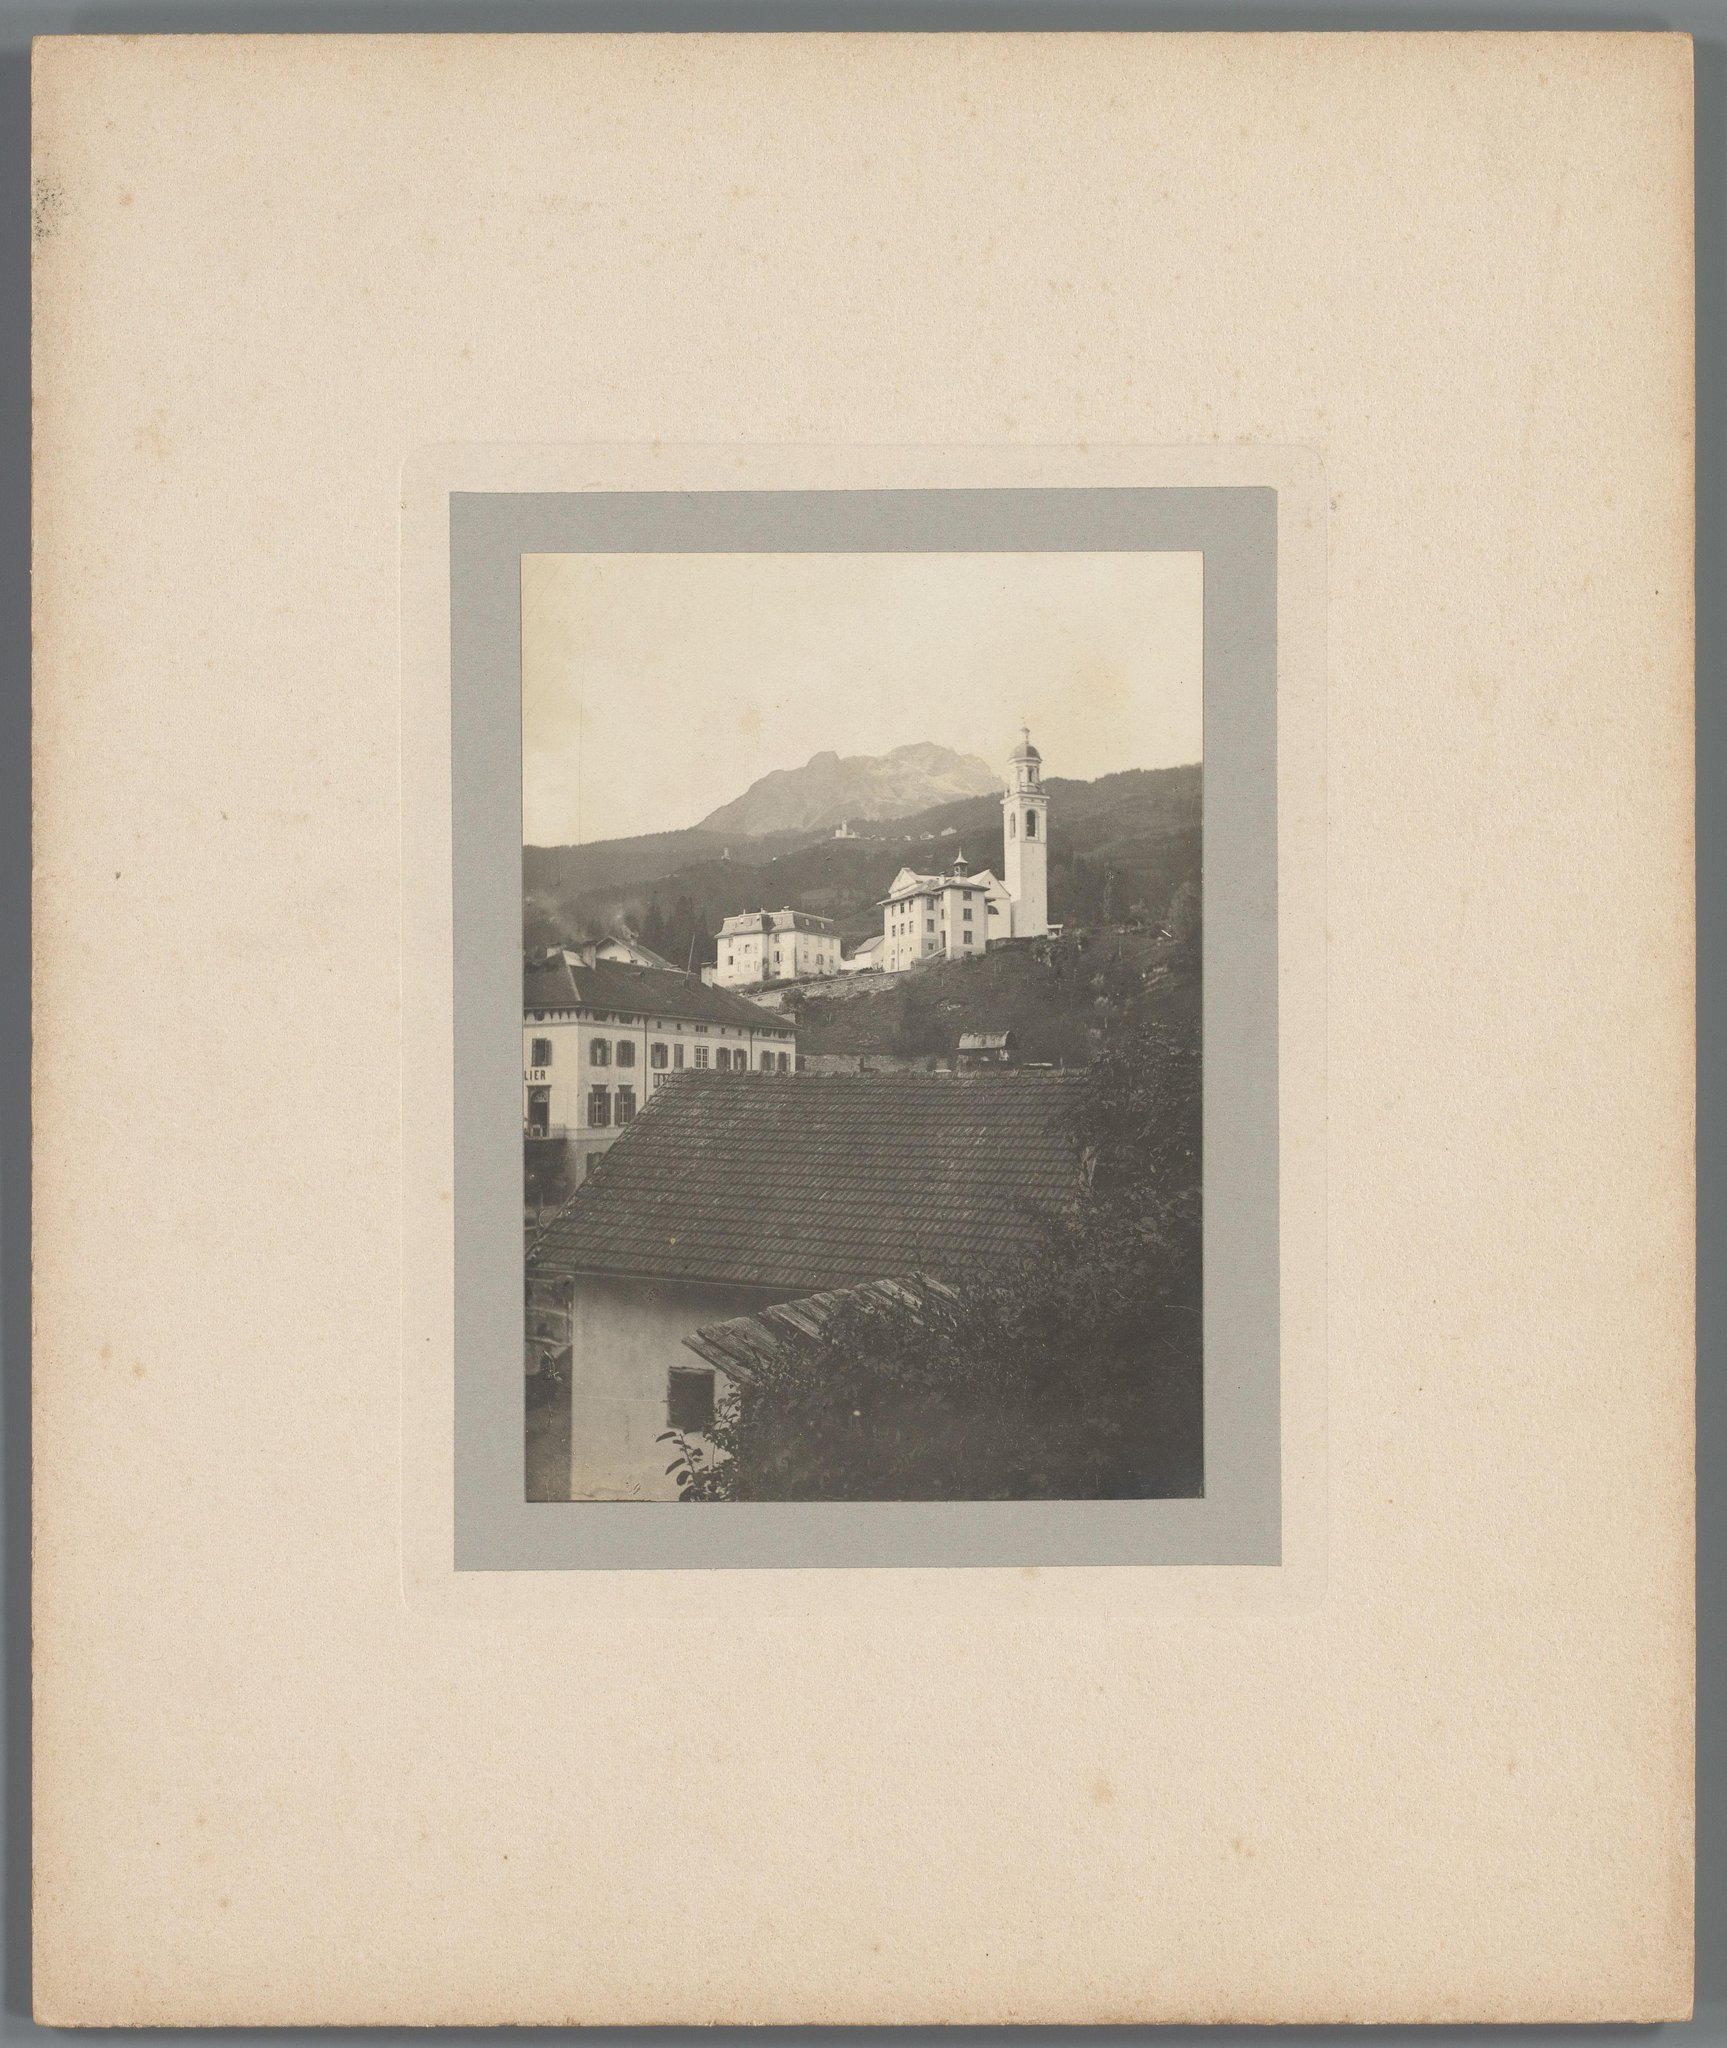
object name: photograph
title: Tiefenkastel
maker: françois buys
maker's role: advocaat, amateurfotograaf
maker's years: 1871-1934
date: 1905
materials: paper, cardboard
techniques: gelatin silver print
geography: switzerland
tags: prospect of village, silhouette of village, church (exterior), mountains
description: Deze foto maakt deel uit van een groep van 38 foto's.